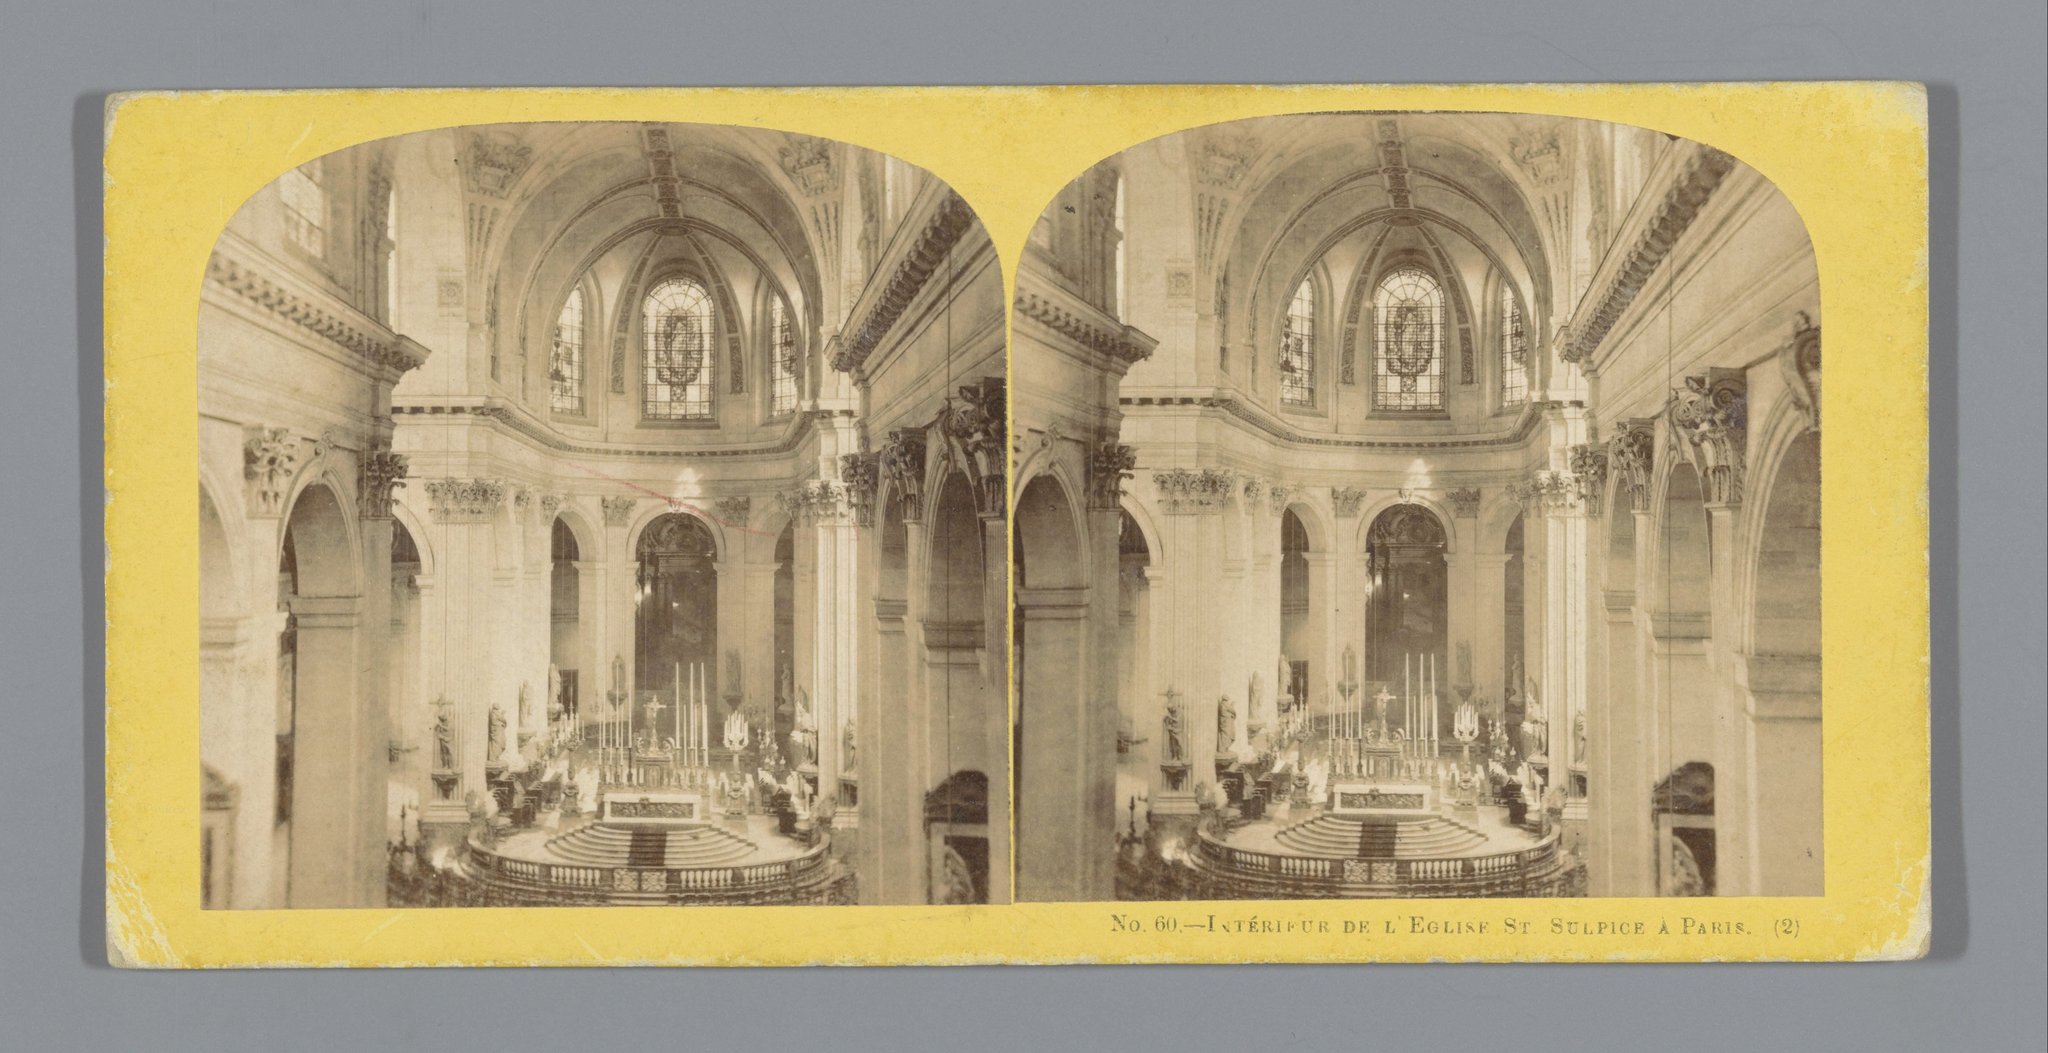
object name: stereograph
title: Interieur van de Église Saint-Sulpice te Parijs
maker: Anonymous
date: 1850-1875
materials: cardboard, photographic support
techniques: albumen print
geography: saint-sulpice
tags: interior of church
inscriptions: number: ‘No. 60.’, number: ‘2’